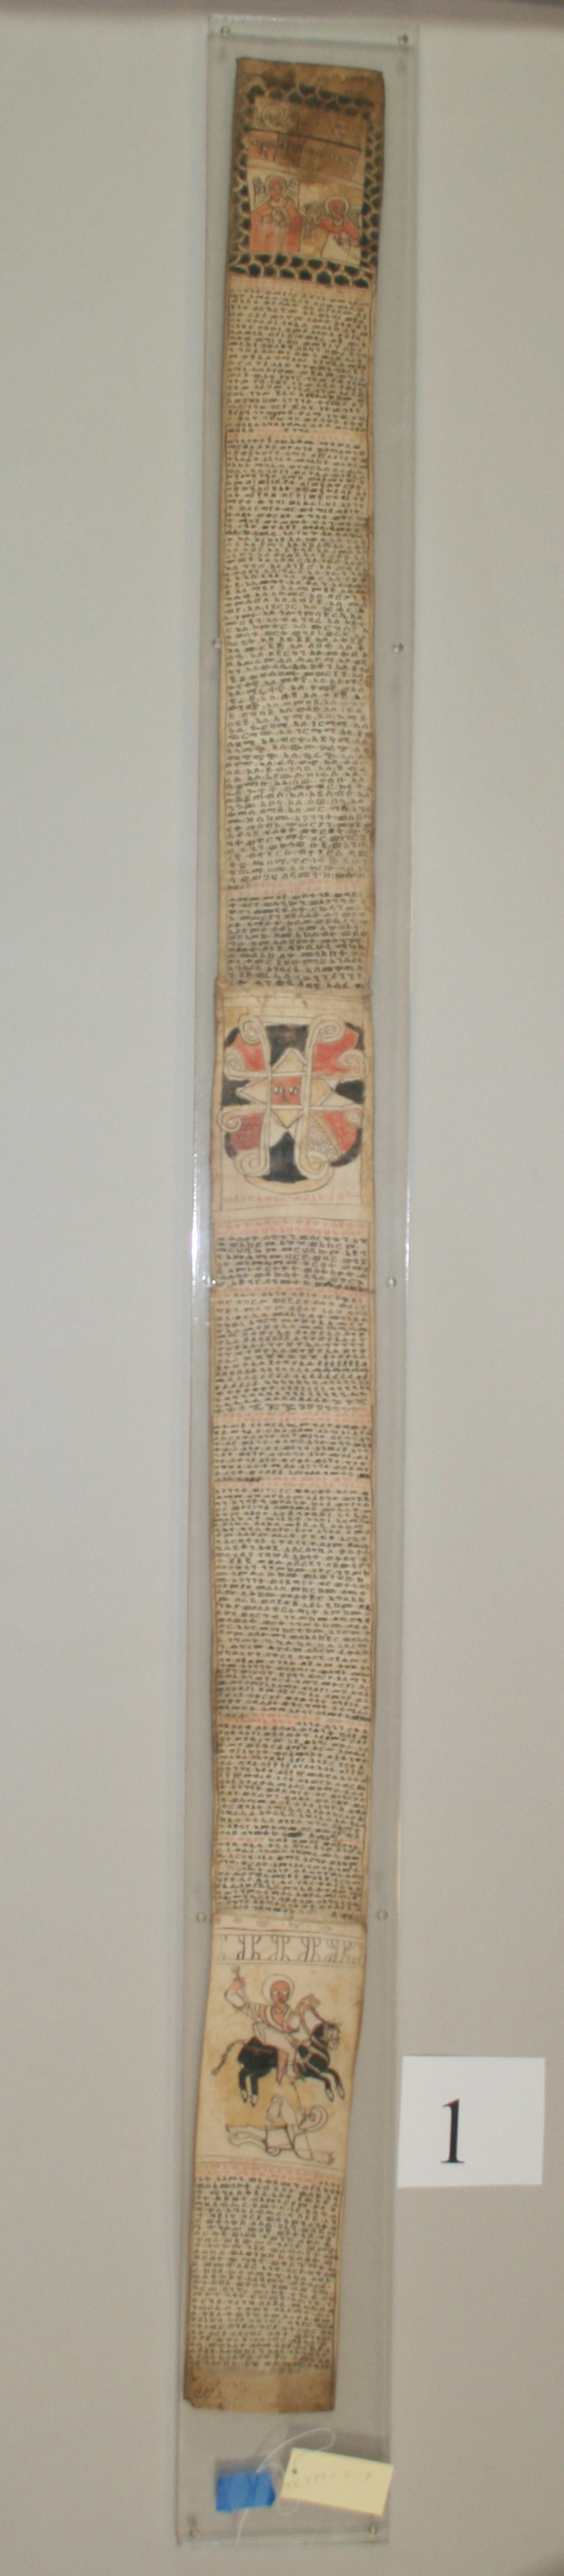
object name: scroll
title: Healing Scroll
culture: amhara or tigrinya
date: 1801-1900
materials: parchment, pigment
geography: ethiopia